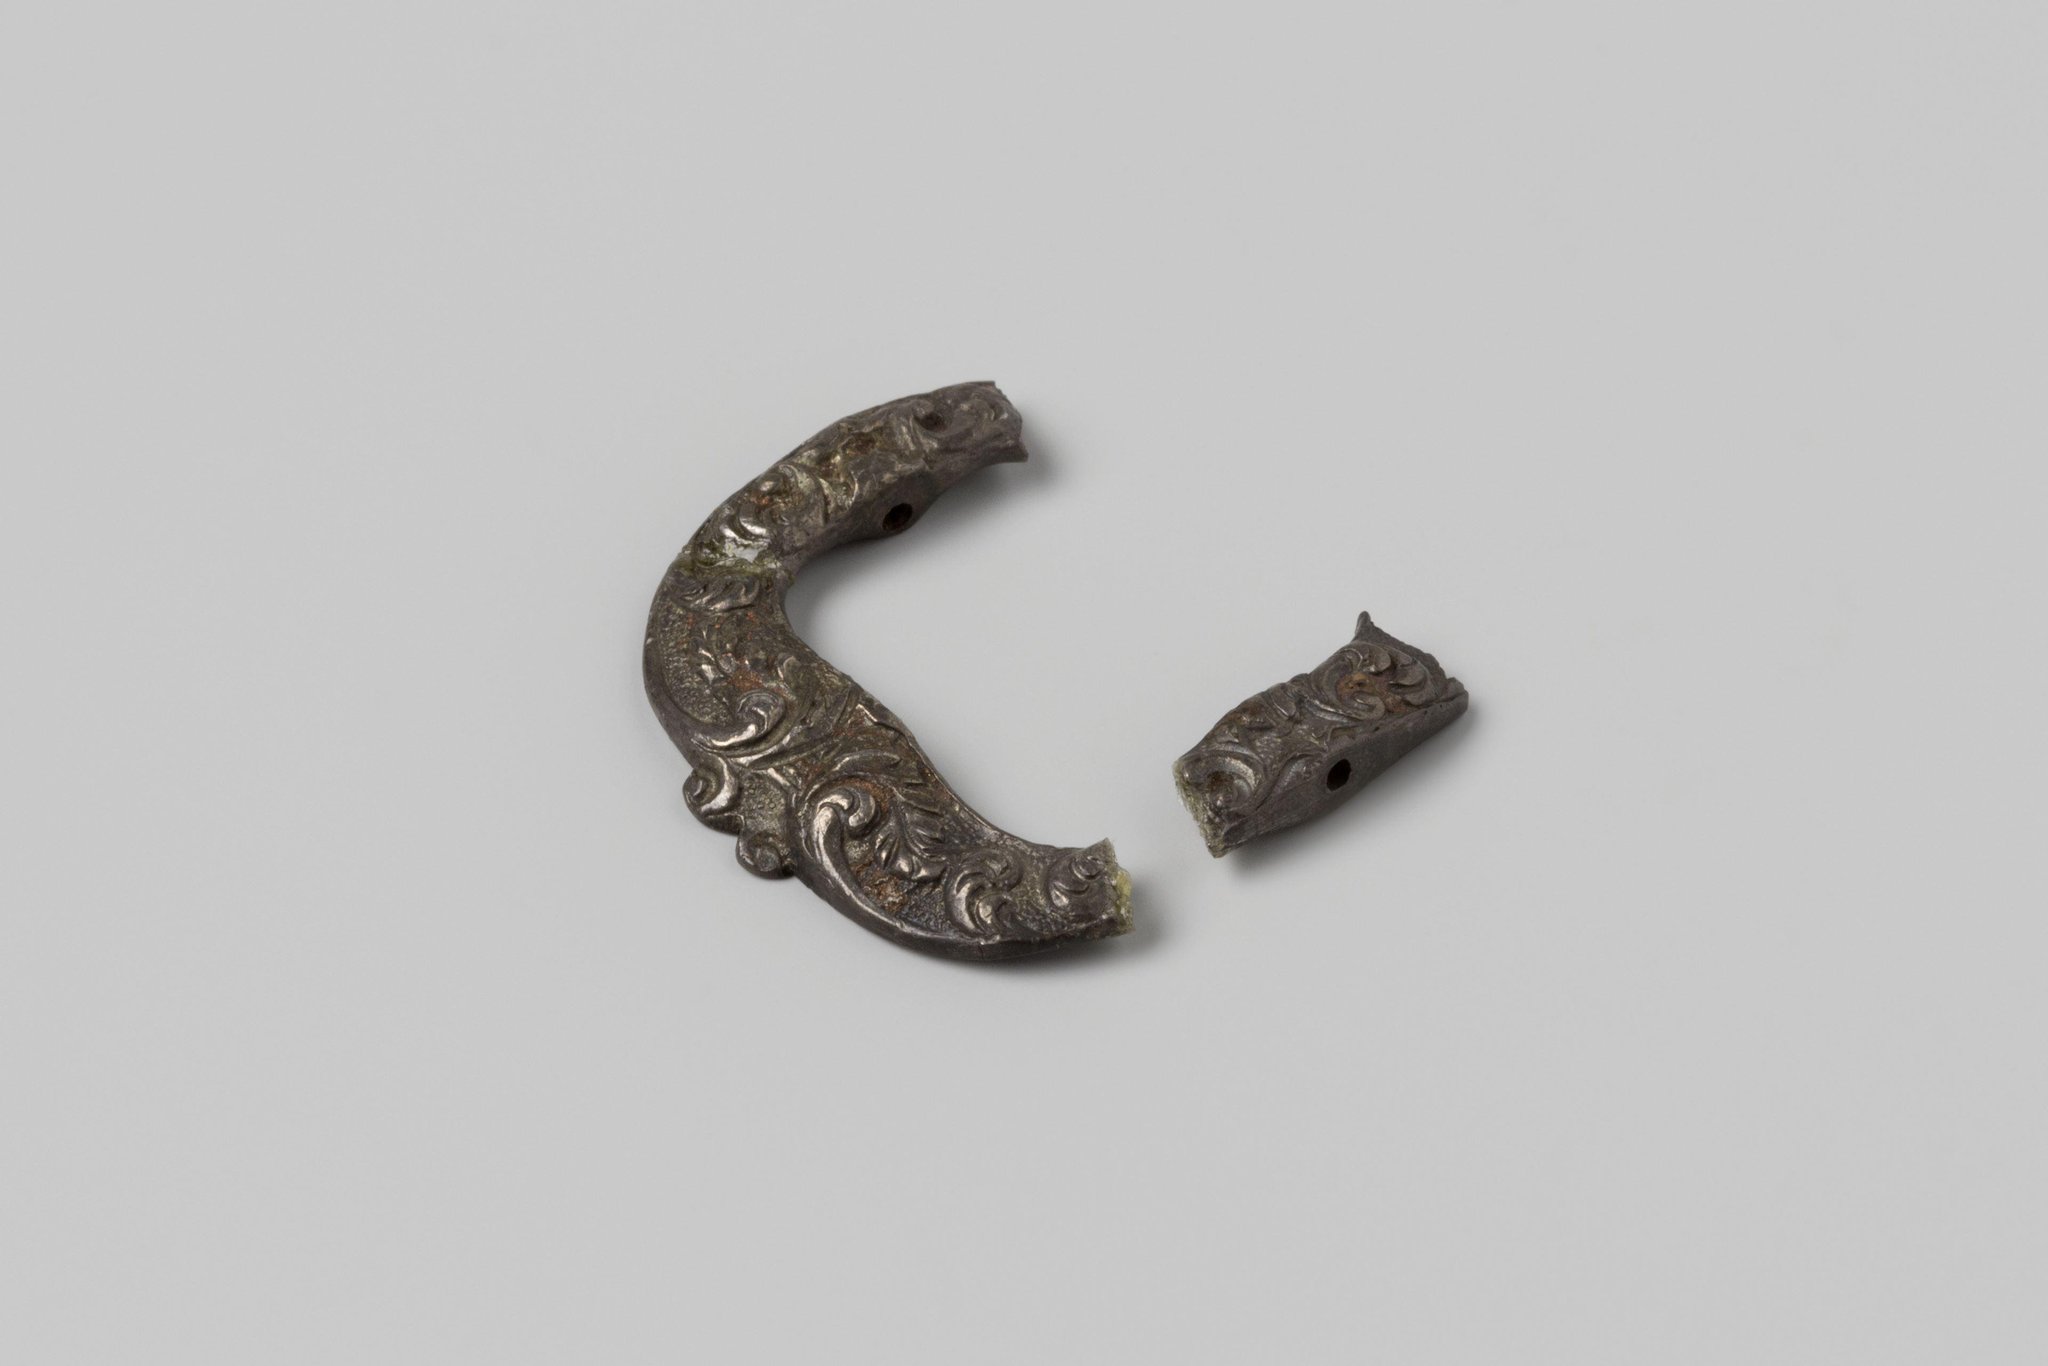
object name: knee buckle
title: Kniegesp uit het wrak van de Oost-Indiëvaarder Hollandia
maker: Anonymous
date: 1700-1743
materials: silver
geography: netherlands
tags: verenigde oostindische compagnie, hollandia (schip), annet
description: Kniegesp, met afgebroken fragment. Buckle, chape buckle, knee buckle; (3) fragment (1) half ring (3l, 0.2t), relieved scrolling and foliate decoration, scrolling projection on the long side (longitudinal spindle)